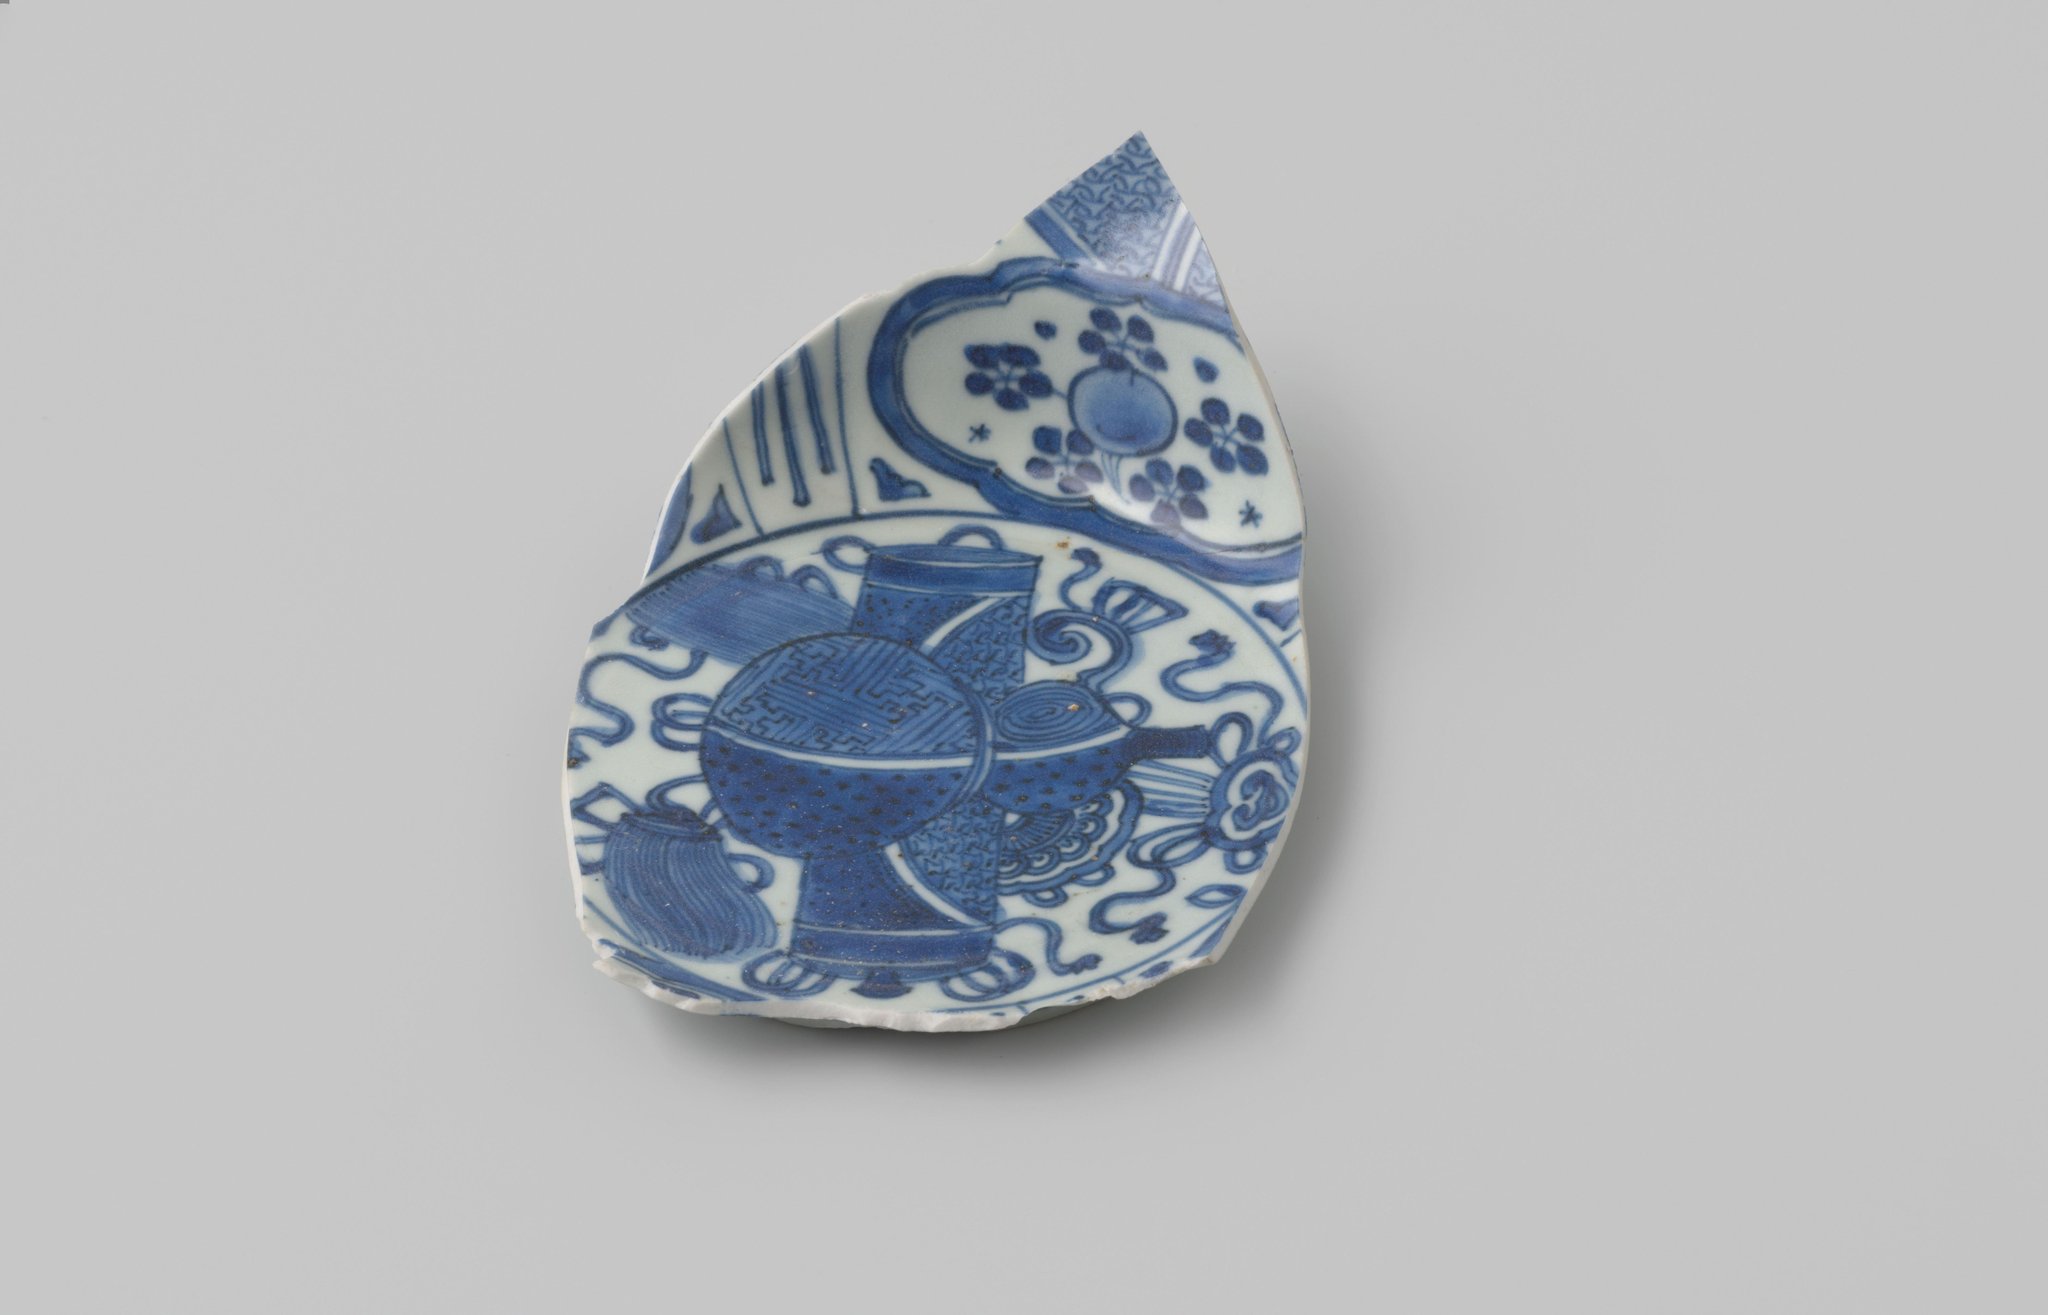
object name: sherd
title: Fragment diep bord uit V.O.C.-schip de 'Witte Leeuw'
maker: Anonymous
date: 1613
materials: bone china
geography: jingdezhen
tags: verenigde oostindische compagnie, sint-helena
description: Fragment diep bord uit V.O.C.-schip de 'Witte Leeuw'.